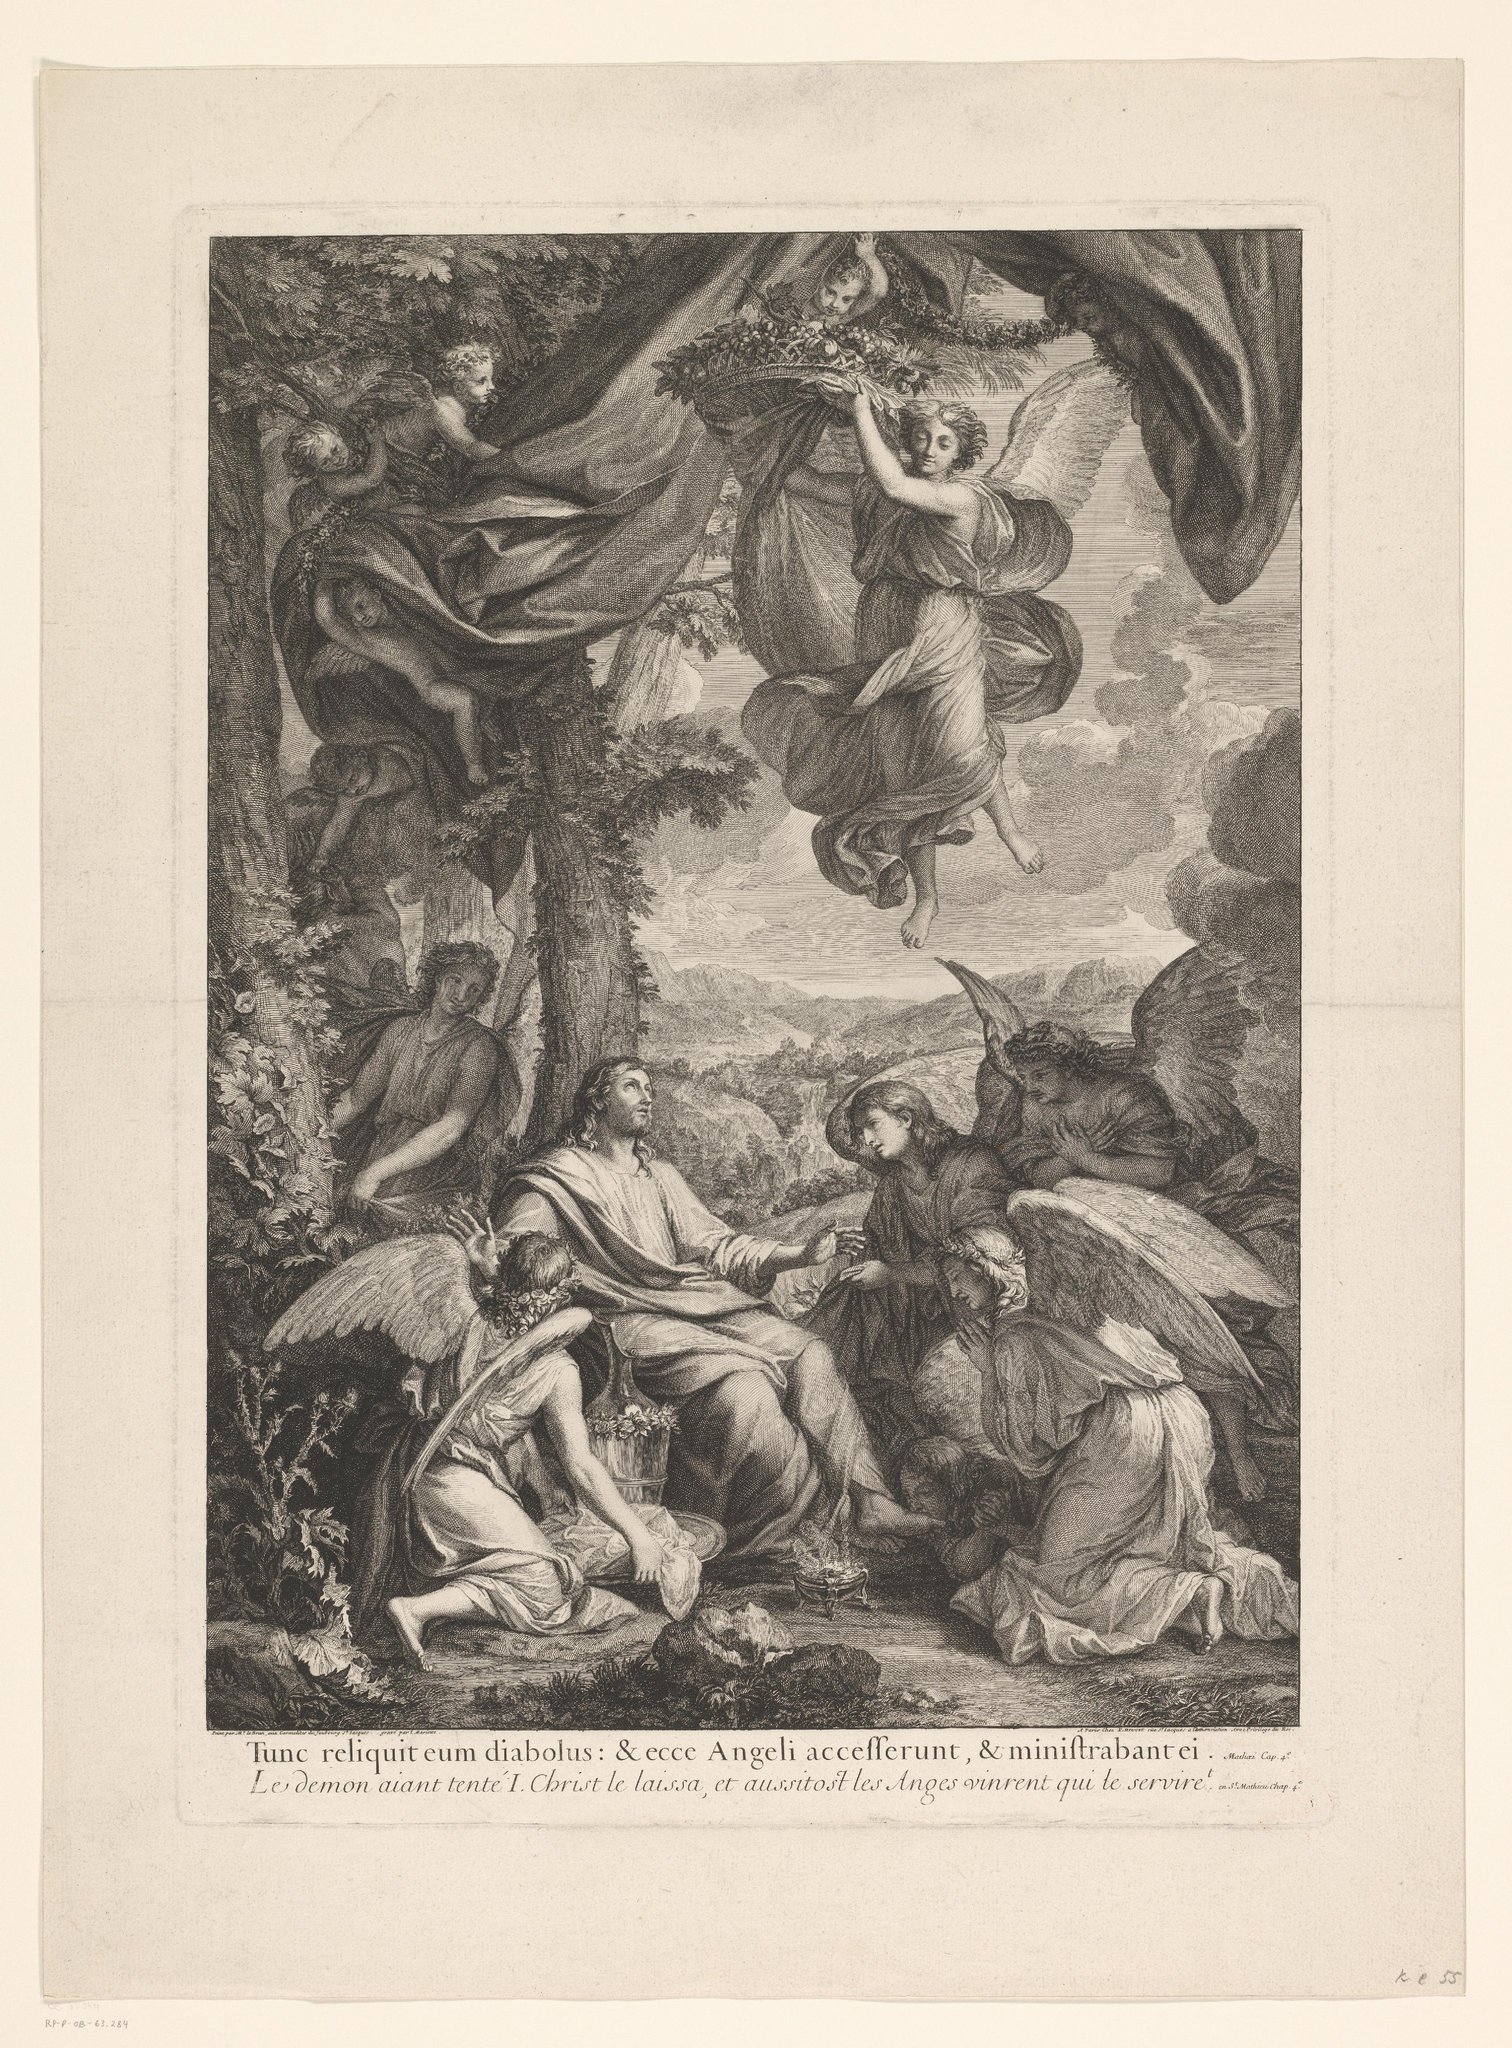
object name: print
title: Christus door de engelen verzorgd na de verzoeking van de duivel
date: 1673-1738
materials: paper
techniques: engraving, etching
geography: paris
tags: christ ministered by angel(s): they bring water and food, sometimes sent by mary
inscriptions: collector's mark: Lugt 240